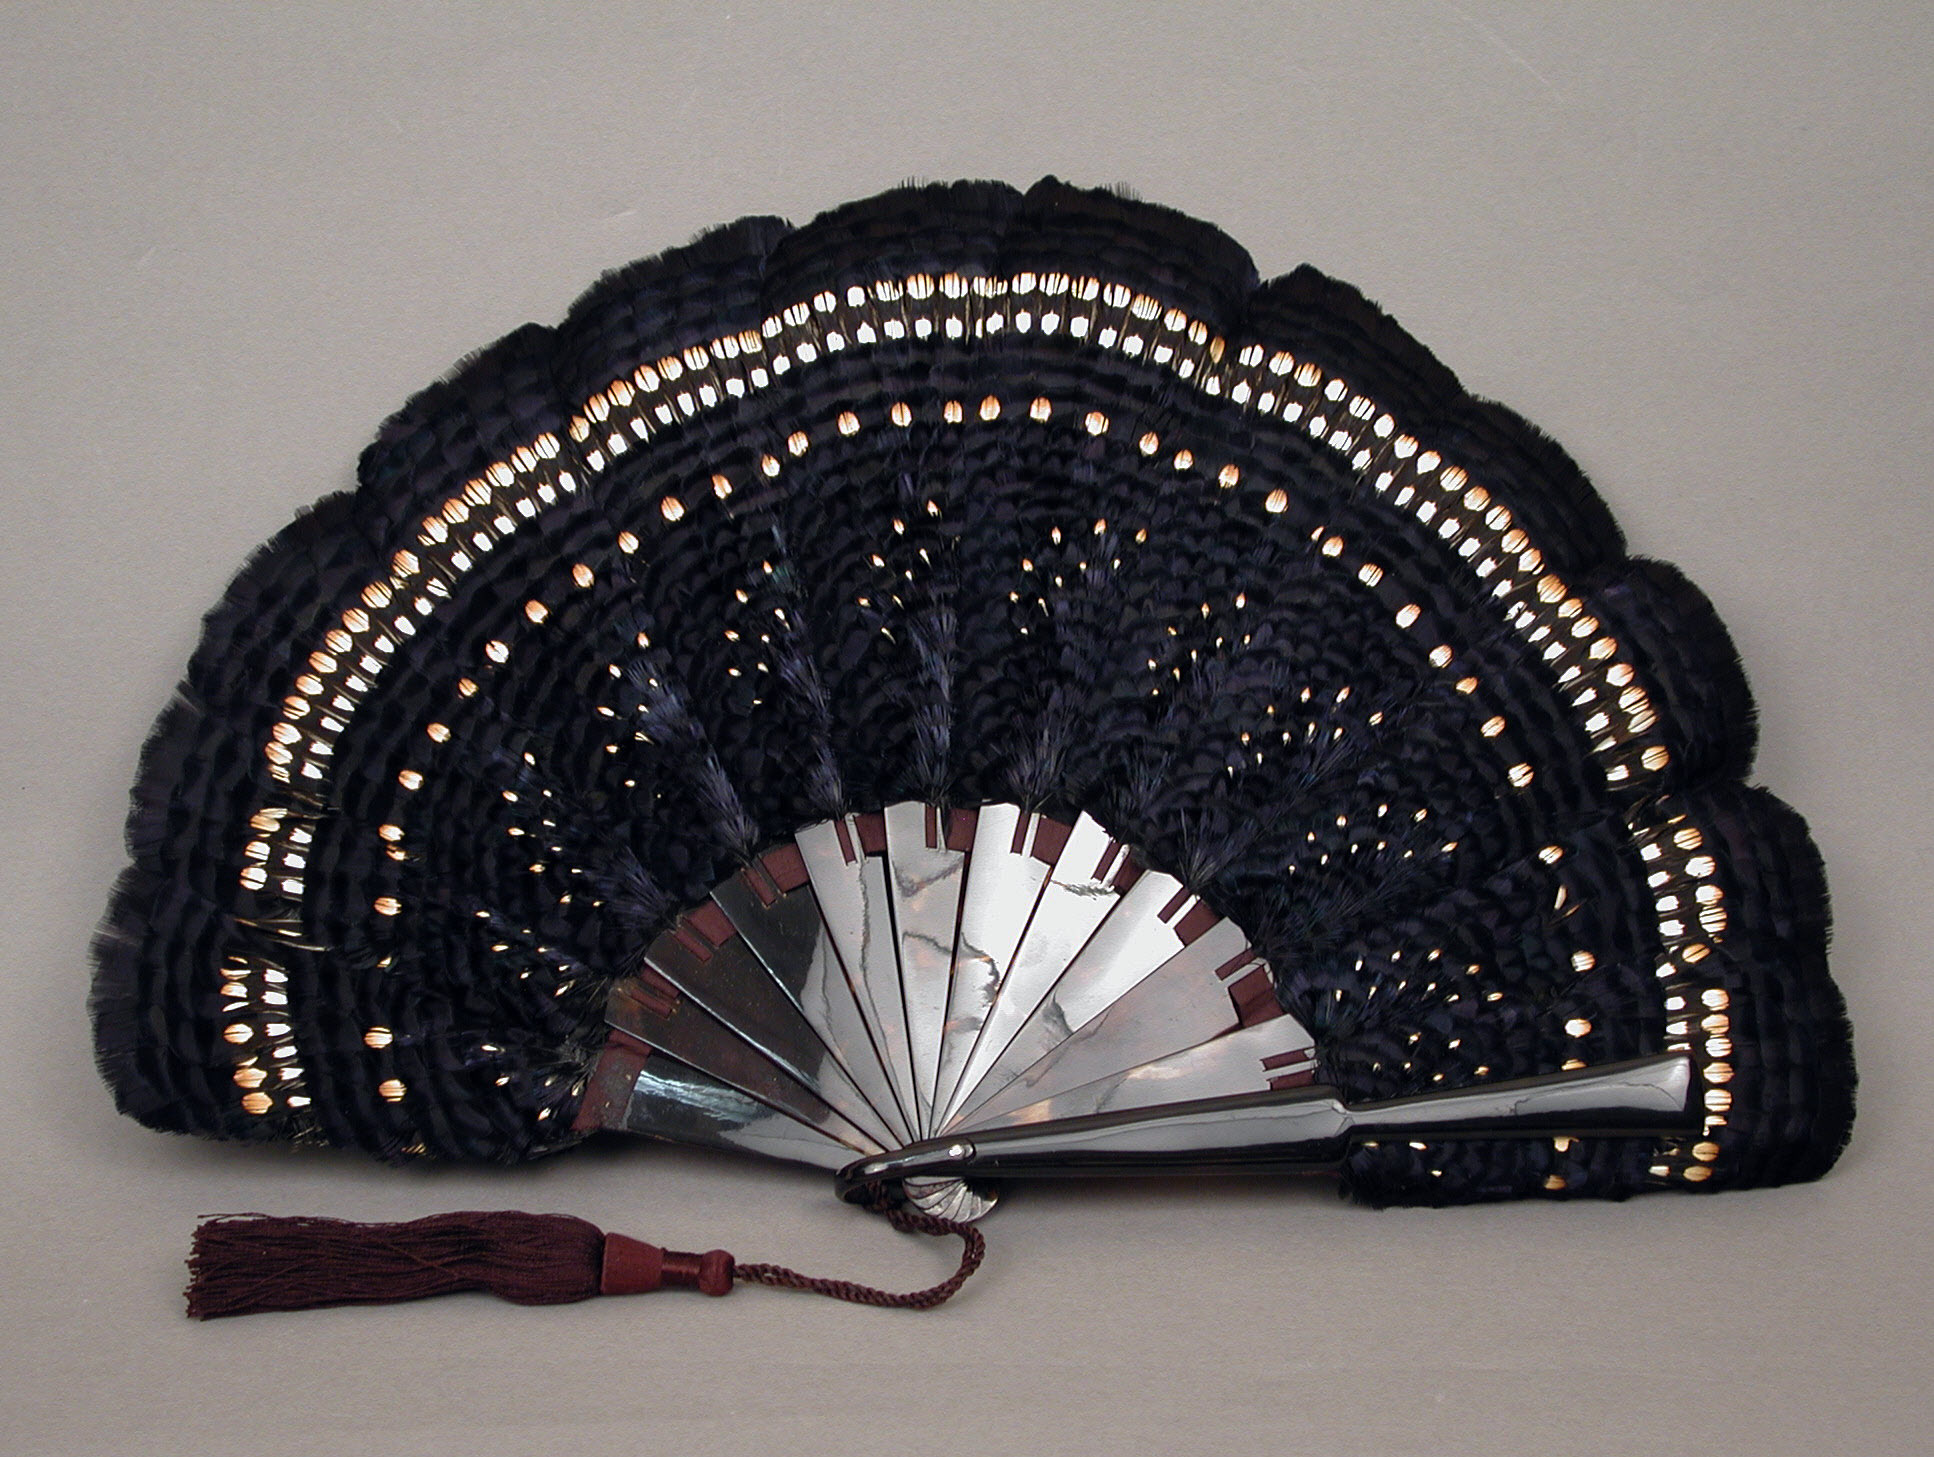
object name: fan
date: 1867-1900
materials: feather, shell